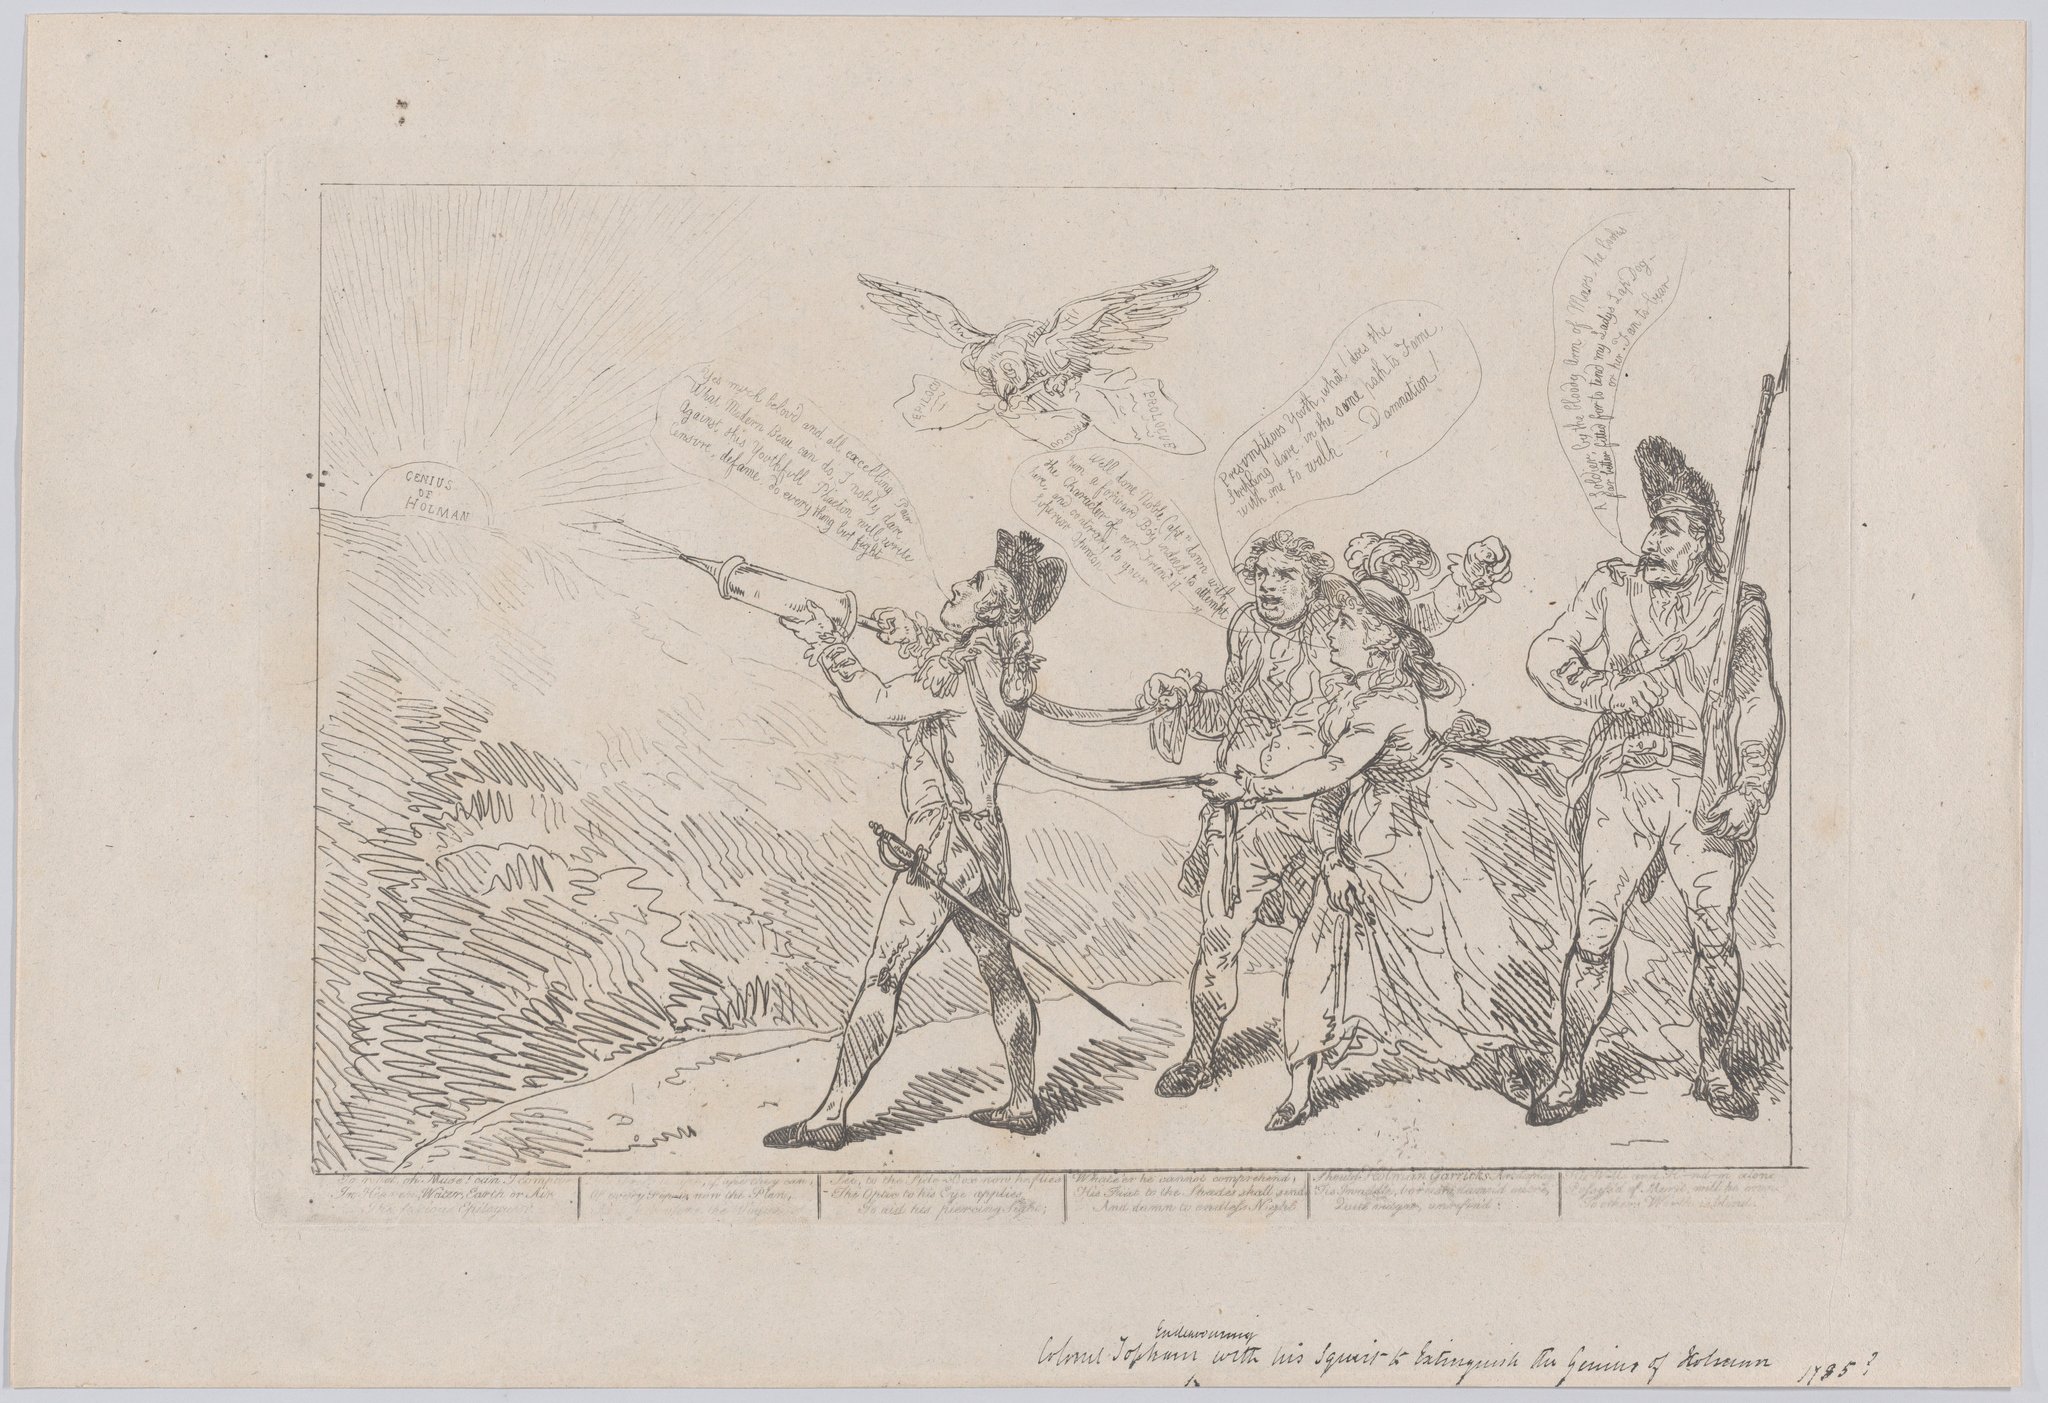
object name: print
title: [Col. Topham Endeavouring, With His Squirt, to Extinguish the Genius of Holman]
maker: thomas rowlandson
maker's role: artist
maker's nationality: british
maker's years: 1757-1827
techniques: etching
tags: satire,men,women,owls